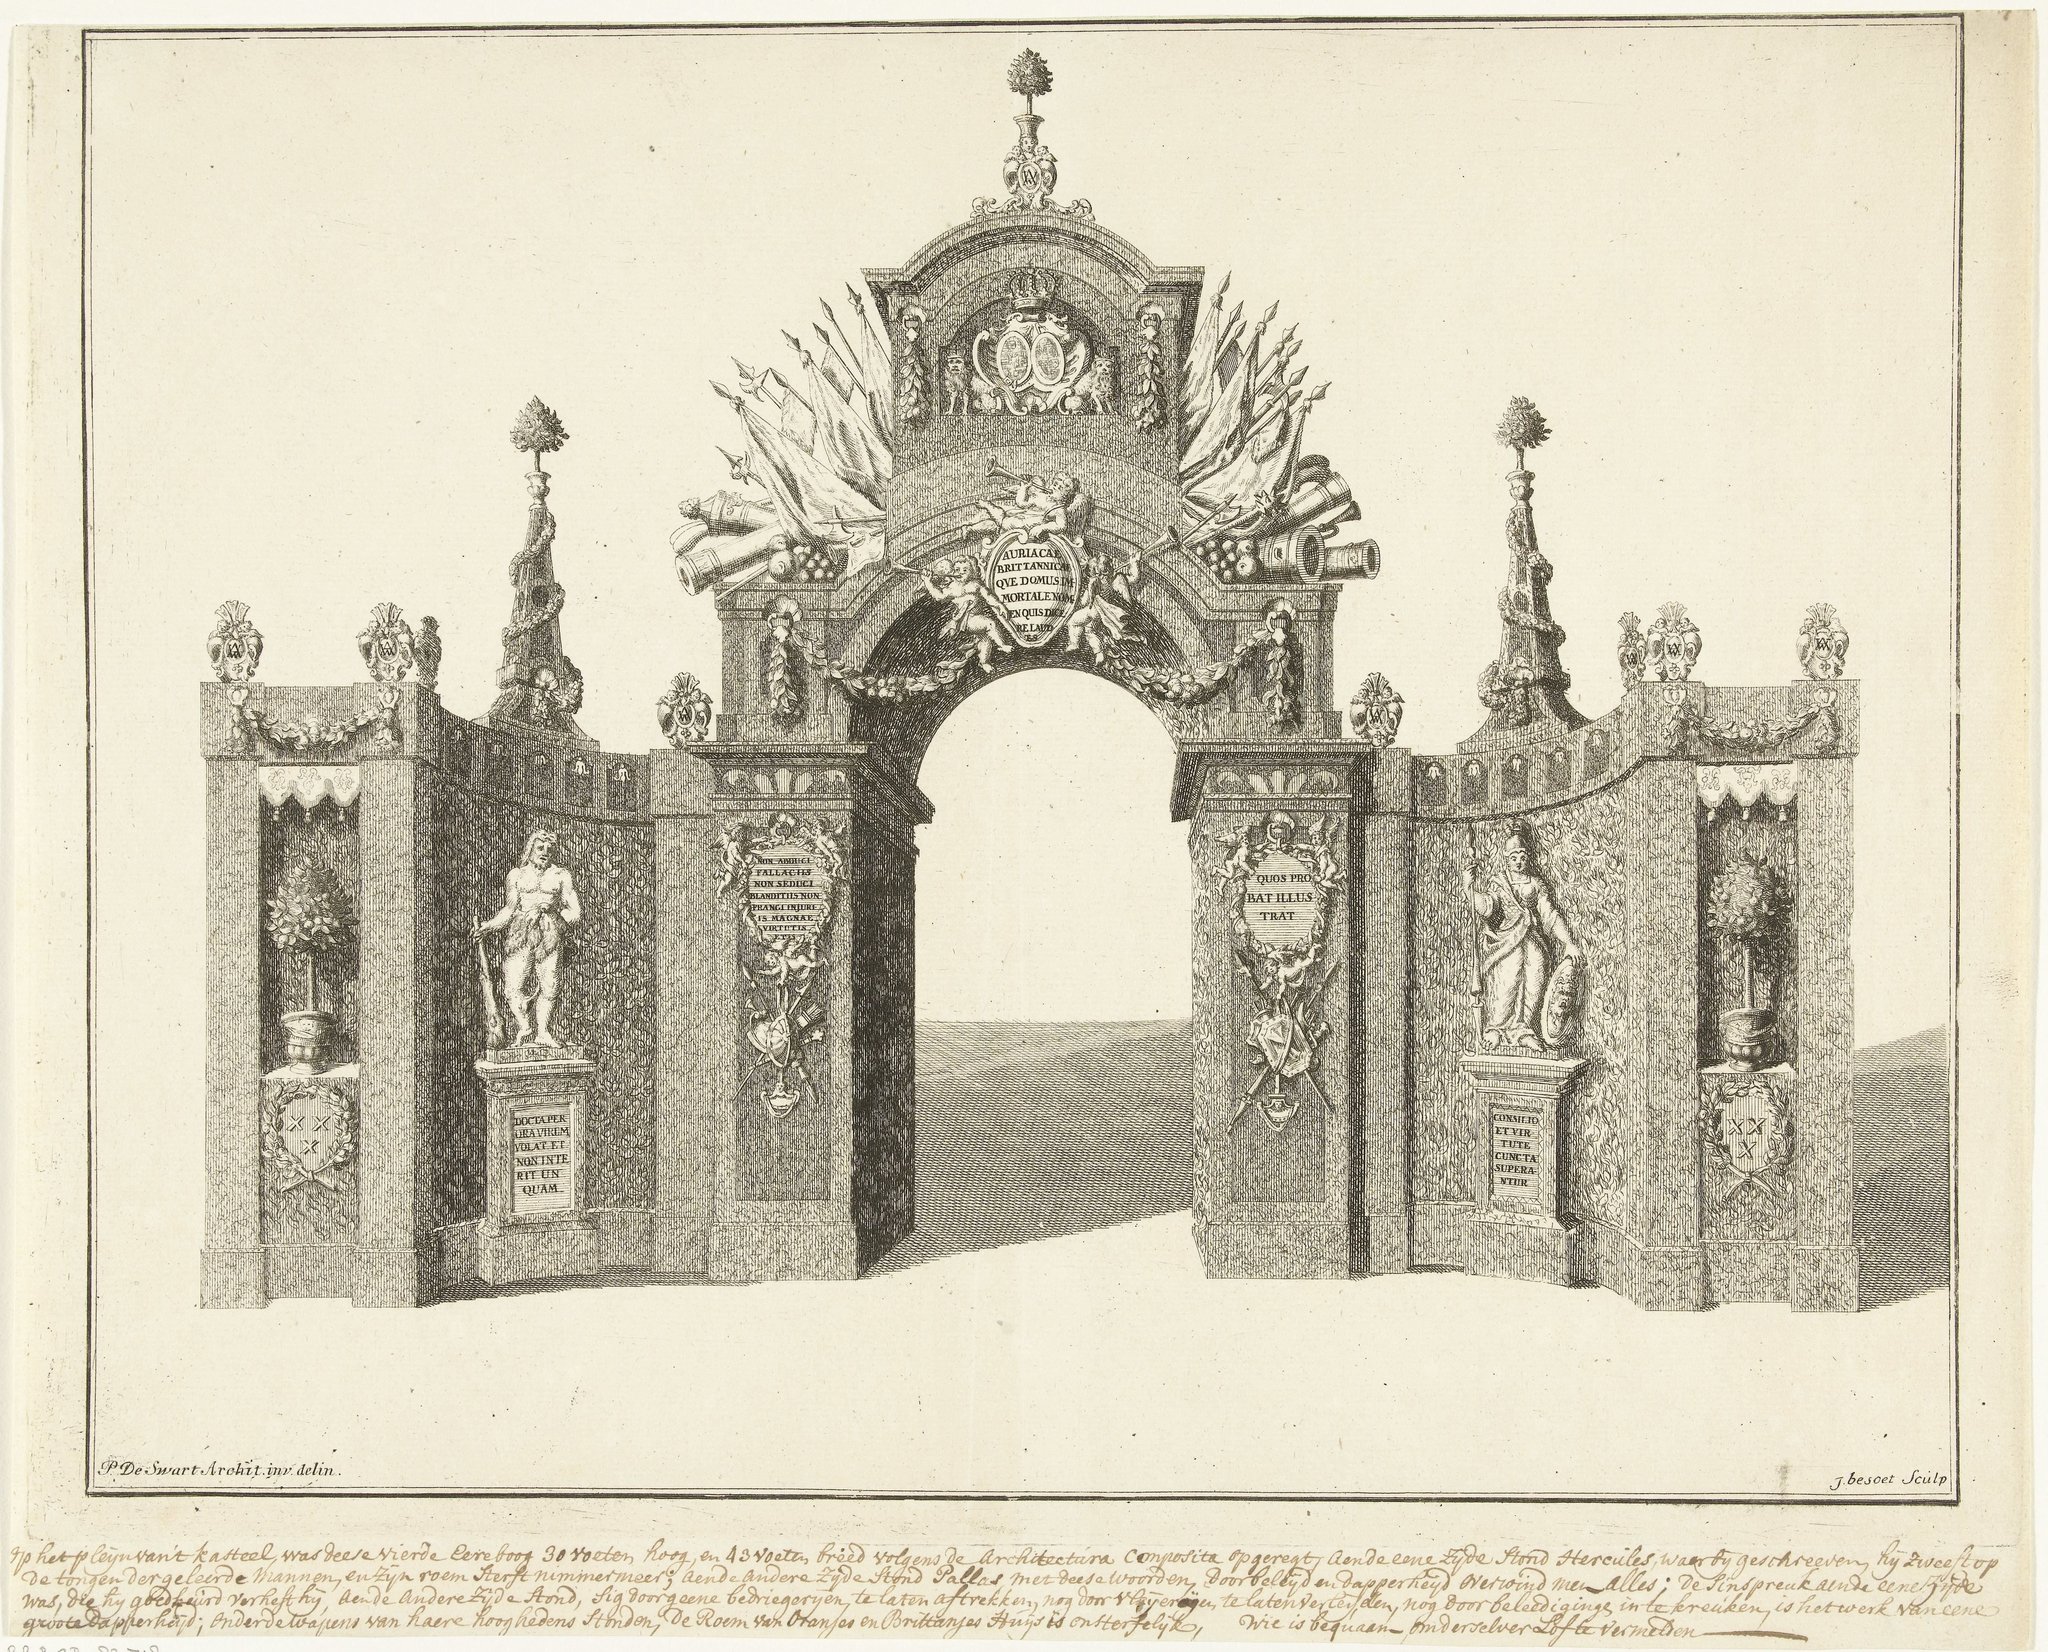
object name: print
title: Ereboog op het plein voor het Kasteel bij de intrede van Willem IV te Breda, 1737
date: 1737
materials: paper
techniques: etching, writing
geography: northern netherlands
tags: willem iv (prins van oranje-nassau), anna van hannover, triumphal arch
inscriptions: collector's mark: Lugt 2228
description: Gebruikt als illustratie in: Het blyde Breda ofte korte verhaal van de plegtige intrede van ... Willem Carel Hendrik Friso ... als Heer en Baron van Breda : ende H.K. Hoogheid Anna ... geschied op den XIII. van herfstmaand, 1737. 's-Gravenhage en Breda: Jacobus van den Kieboom & Johannnes van den Kieboom, 1737.